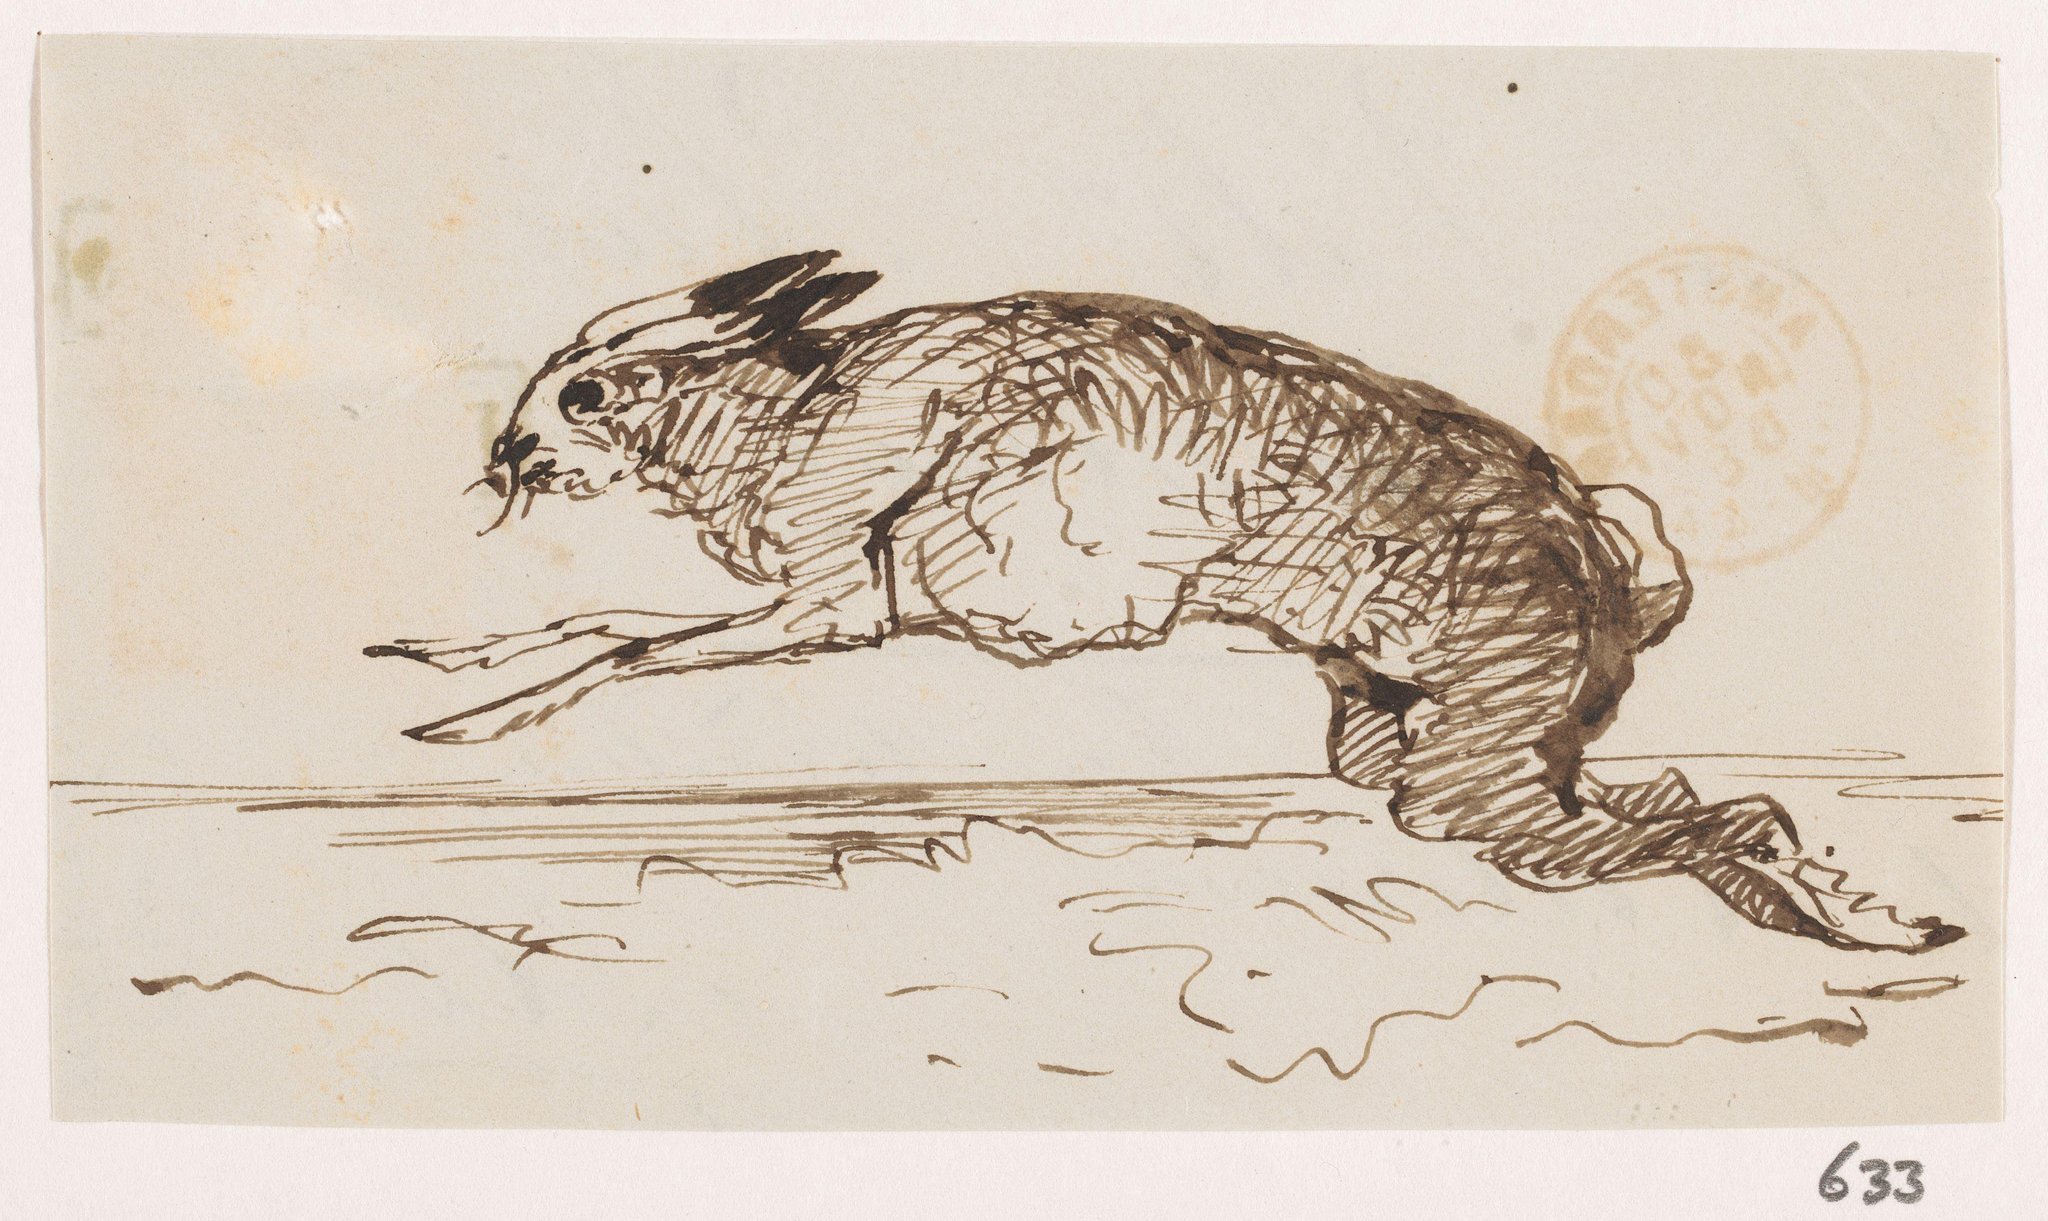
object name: drawing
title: Haas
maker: johannes tavenraat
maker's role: draughtsman, painter, print maker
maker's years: 1809-1881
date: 1868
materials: ink, paper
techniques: pen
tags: rodents: hare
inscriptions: collector's mark: Lugt 2228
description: Haas. Getekend op de achterzijde van een deel van een envelop of brief gericht aan J. Tavenraat, met poststempel 30 november 1868.